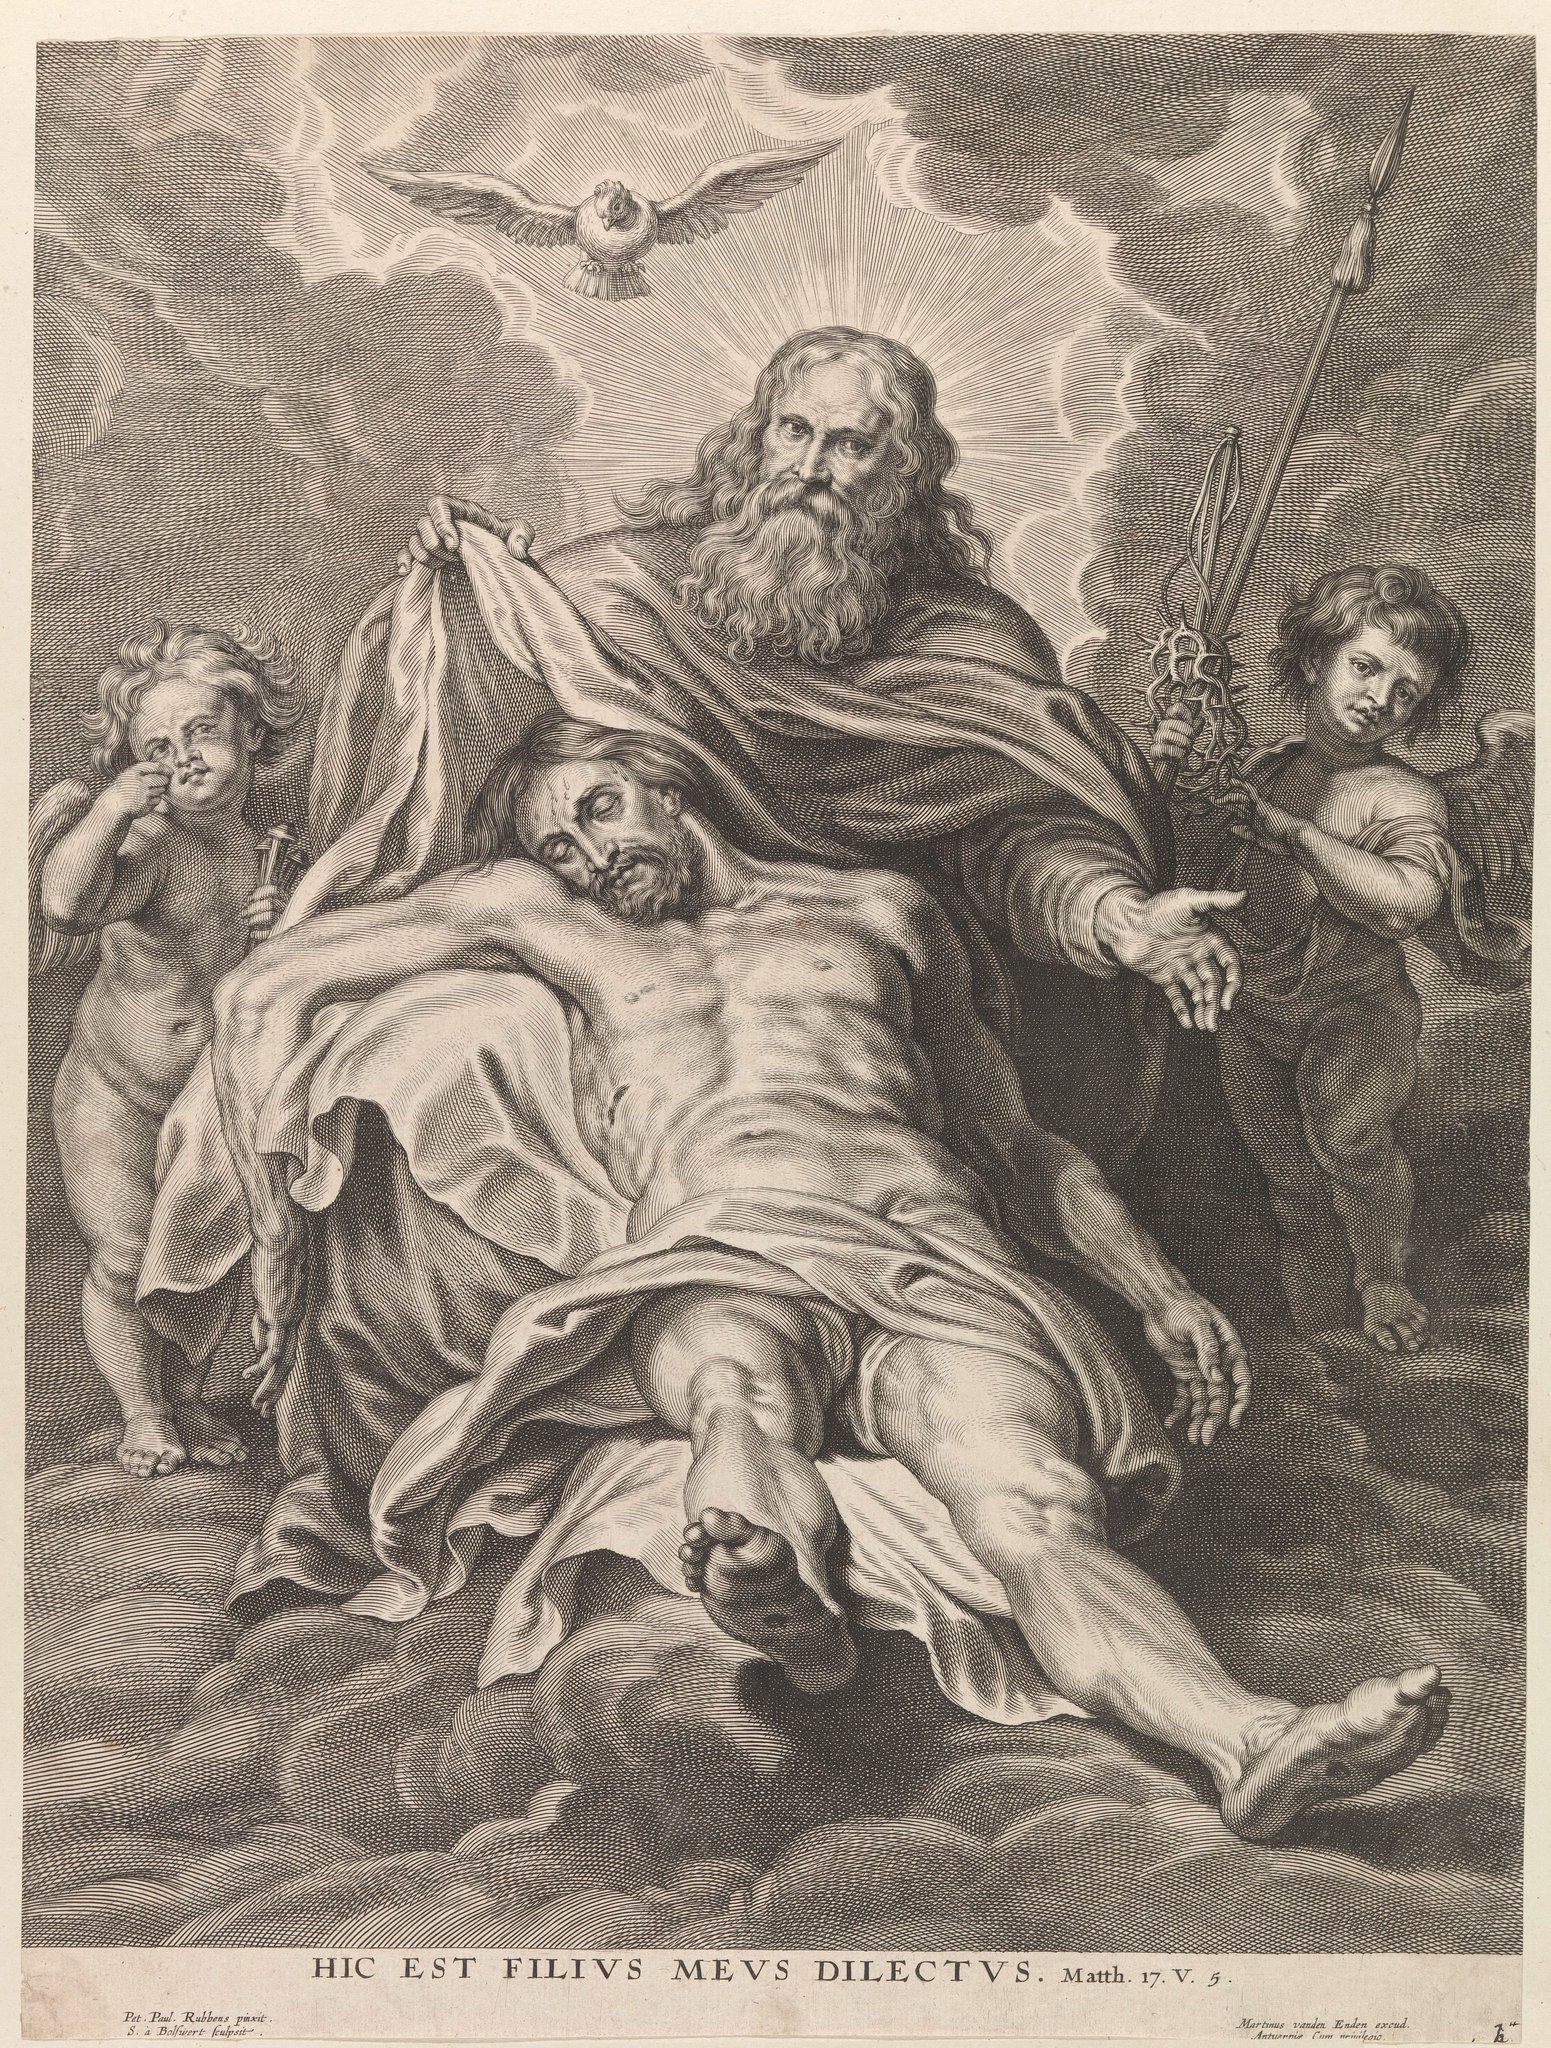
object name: album leaf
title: Heilige Drieëenheid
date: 1596-1659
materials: paper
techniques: engraving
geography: antwerp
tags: 'arma christi', god the father holding the crucified or dead christ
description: Heilige Drieëenheid in de wolken: God de Vader met op zijn schoot het lichaam van Christus en boven zijn hoofd de Heilige Geest in de gedaante van een duif. Twee kleine engelen aan weerszijden houden lijdenswerktuigen vast. Onder de voorstelling citaat uit Mat. 17:5. Deze prent maakt deel uit van een album.